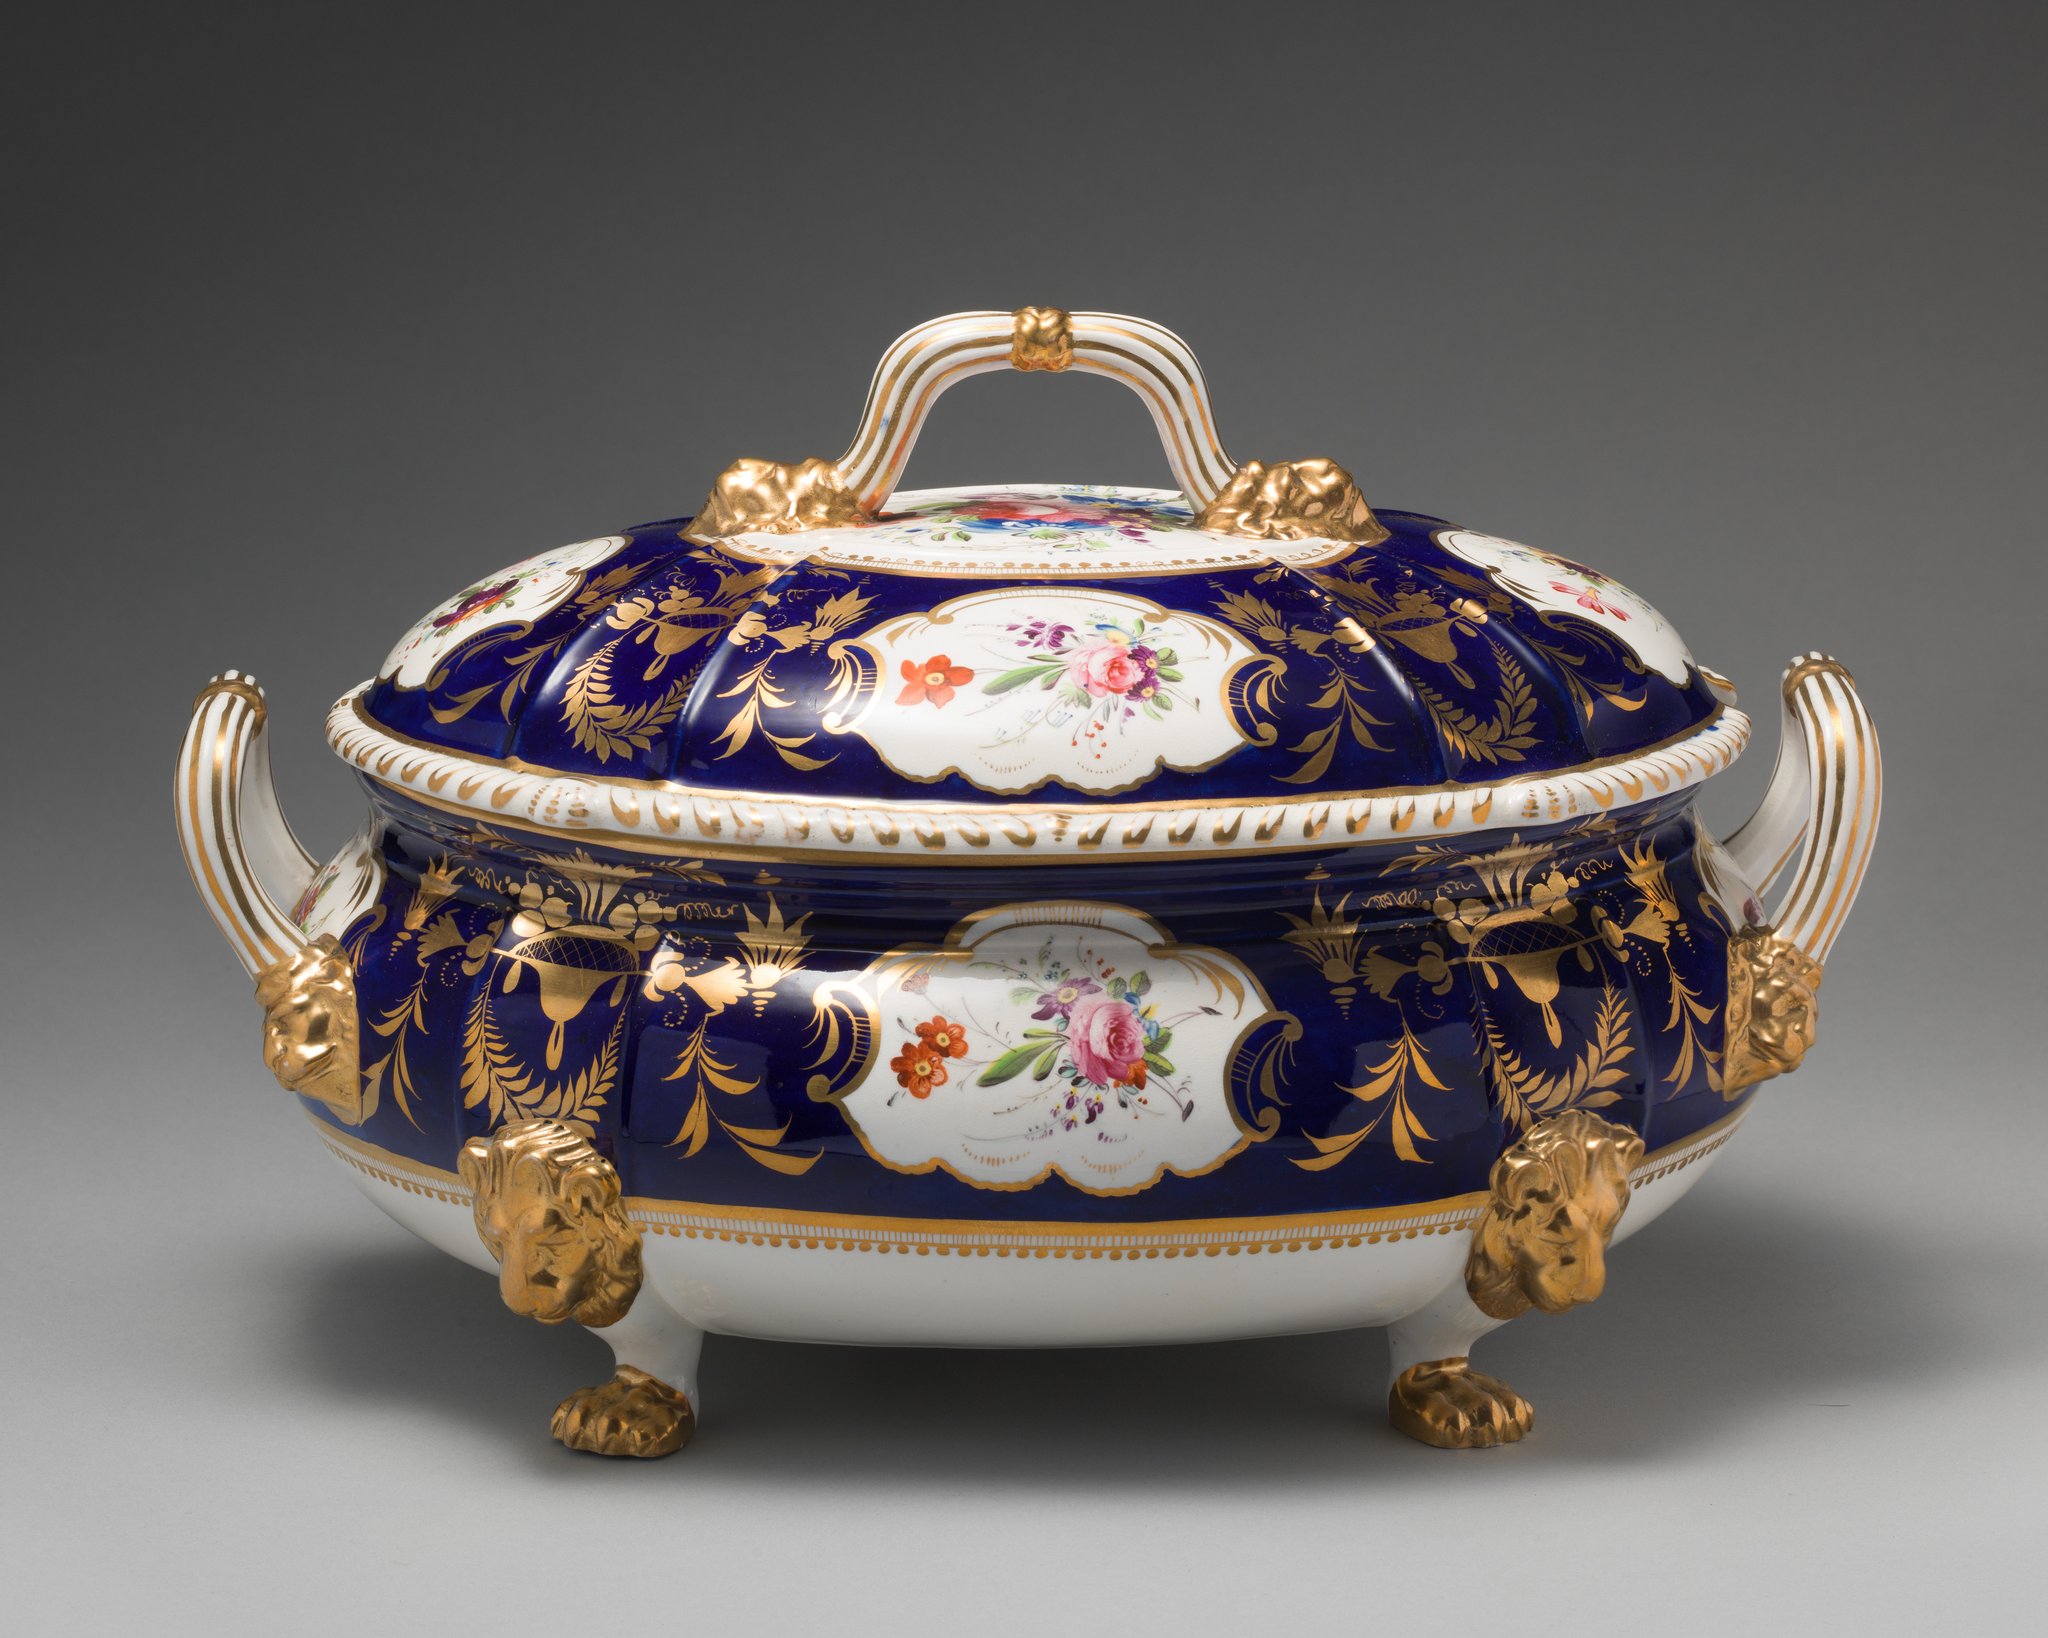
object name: tureen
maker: crown derby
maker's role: maker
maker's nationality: british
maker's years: 1750-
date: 1814-1830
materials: soft paste porcelain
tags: flowers